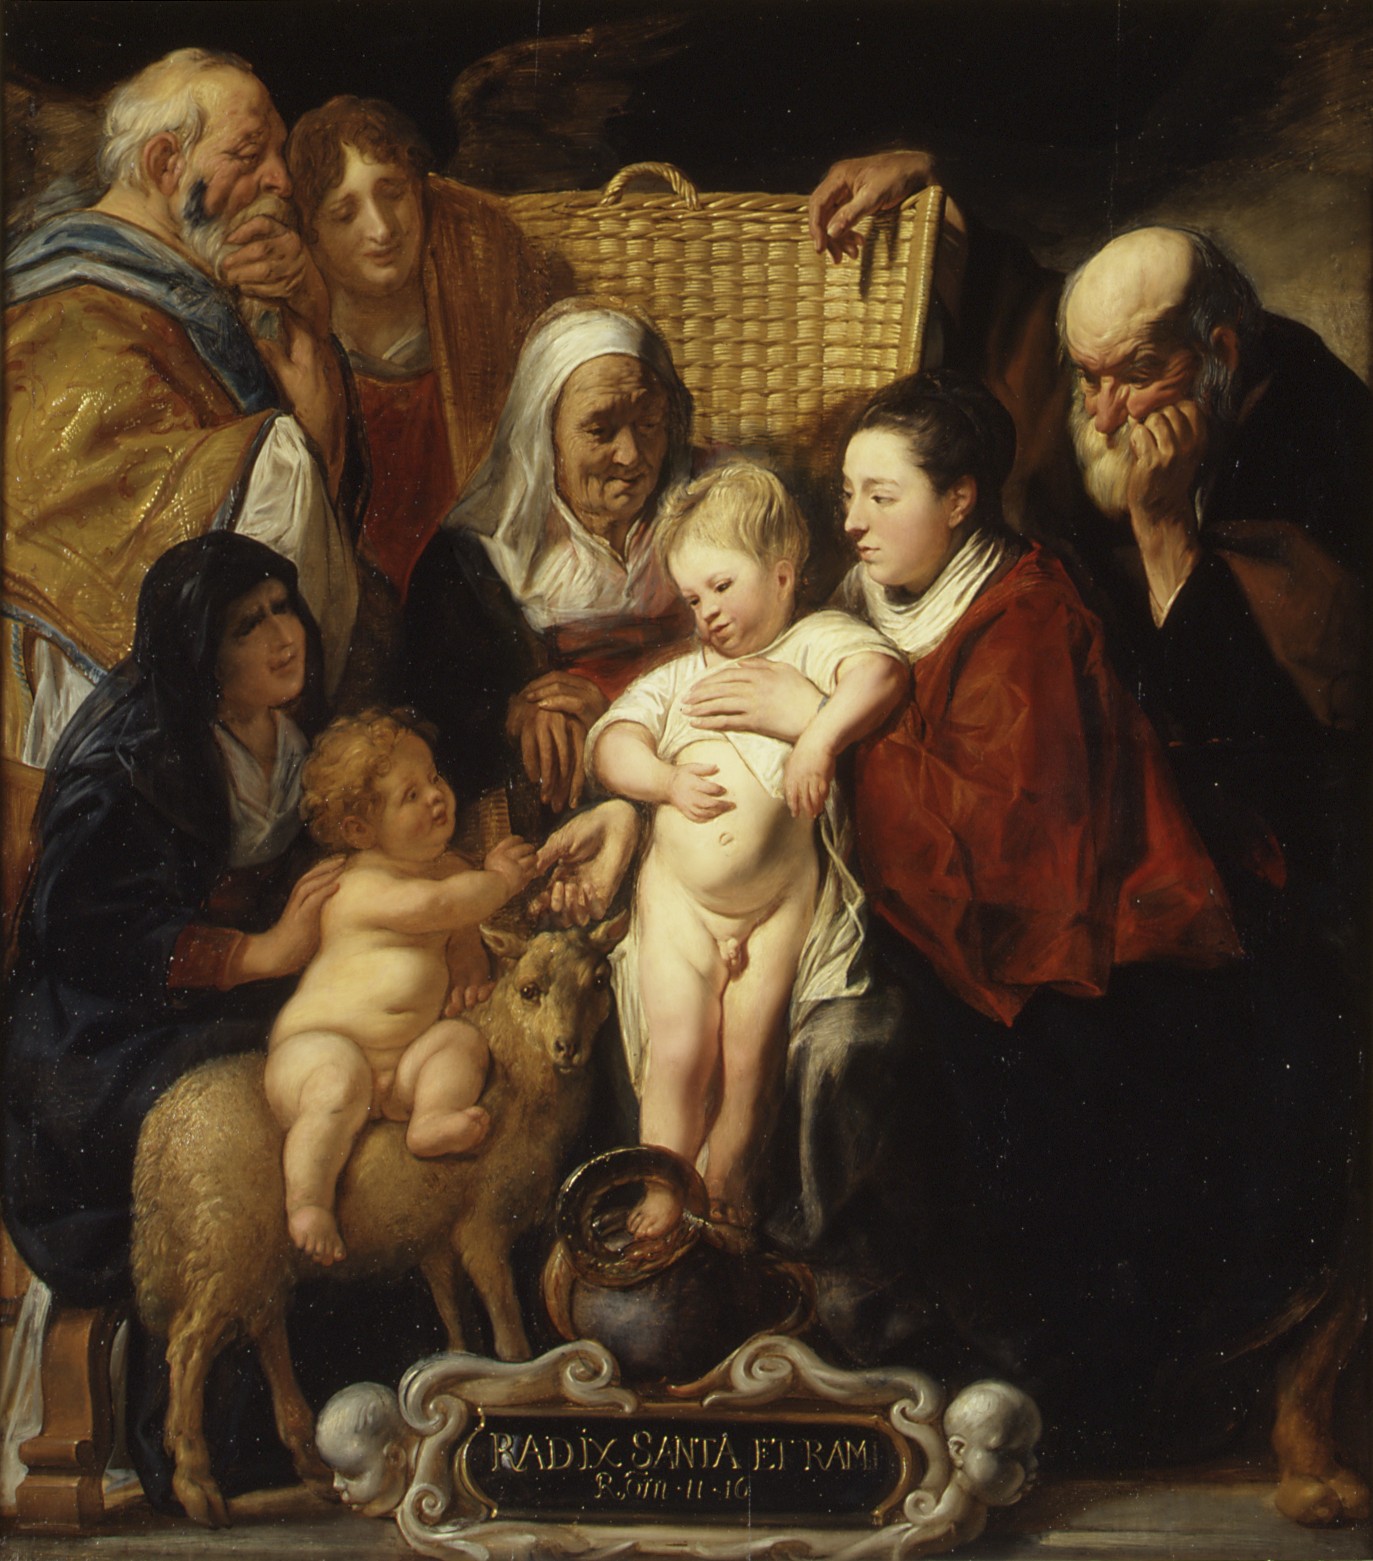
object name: painting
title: The Holy Family with Saint Anne and the Young Baptist and His Parents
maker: jacob jordaens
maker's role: artist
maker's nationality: flemish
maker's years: 1593-1678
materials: oil, wood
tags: sheep,holy family,saint anne,saint john the baptist,virgin mary,jesus